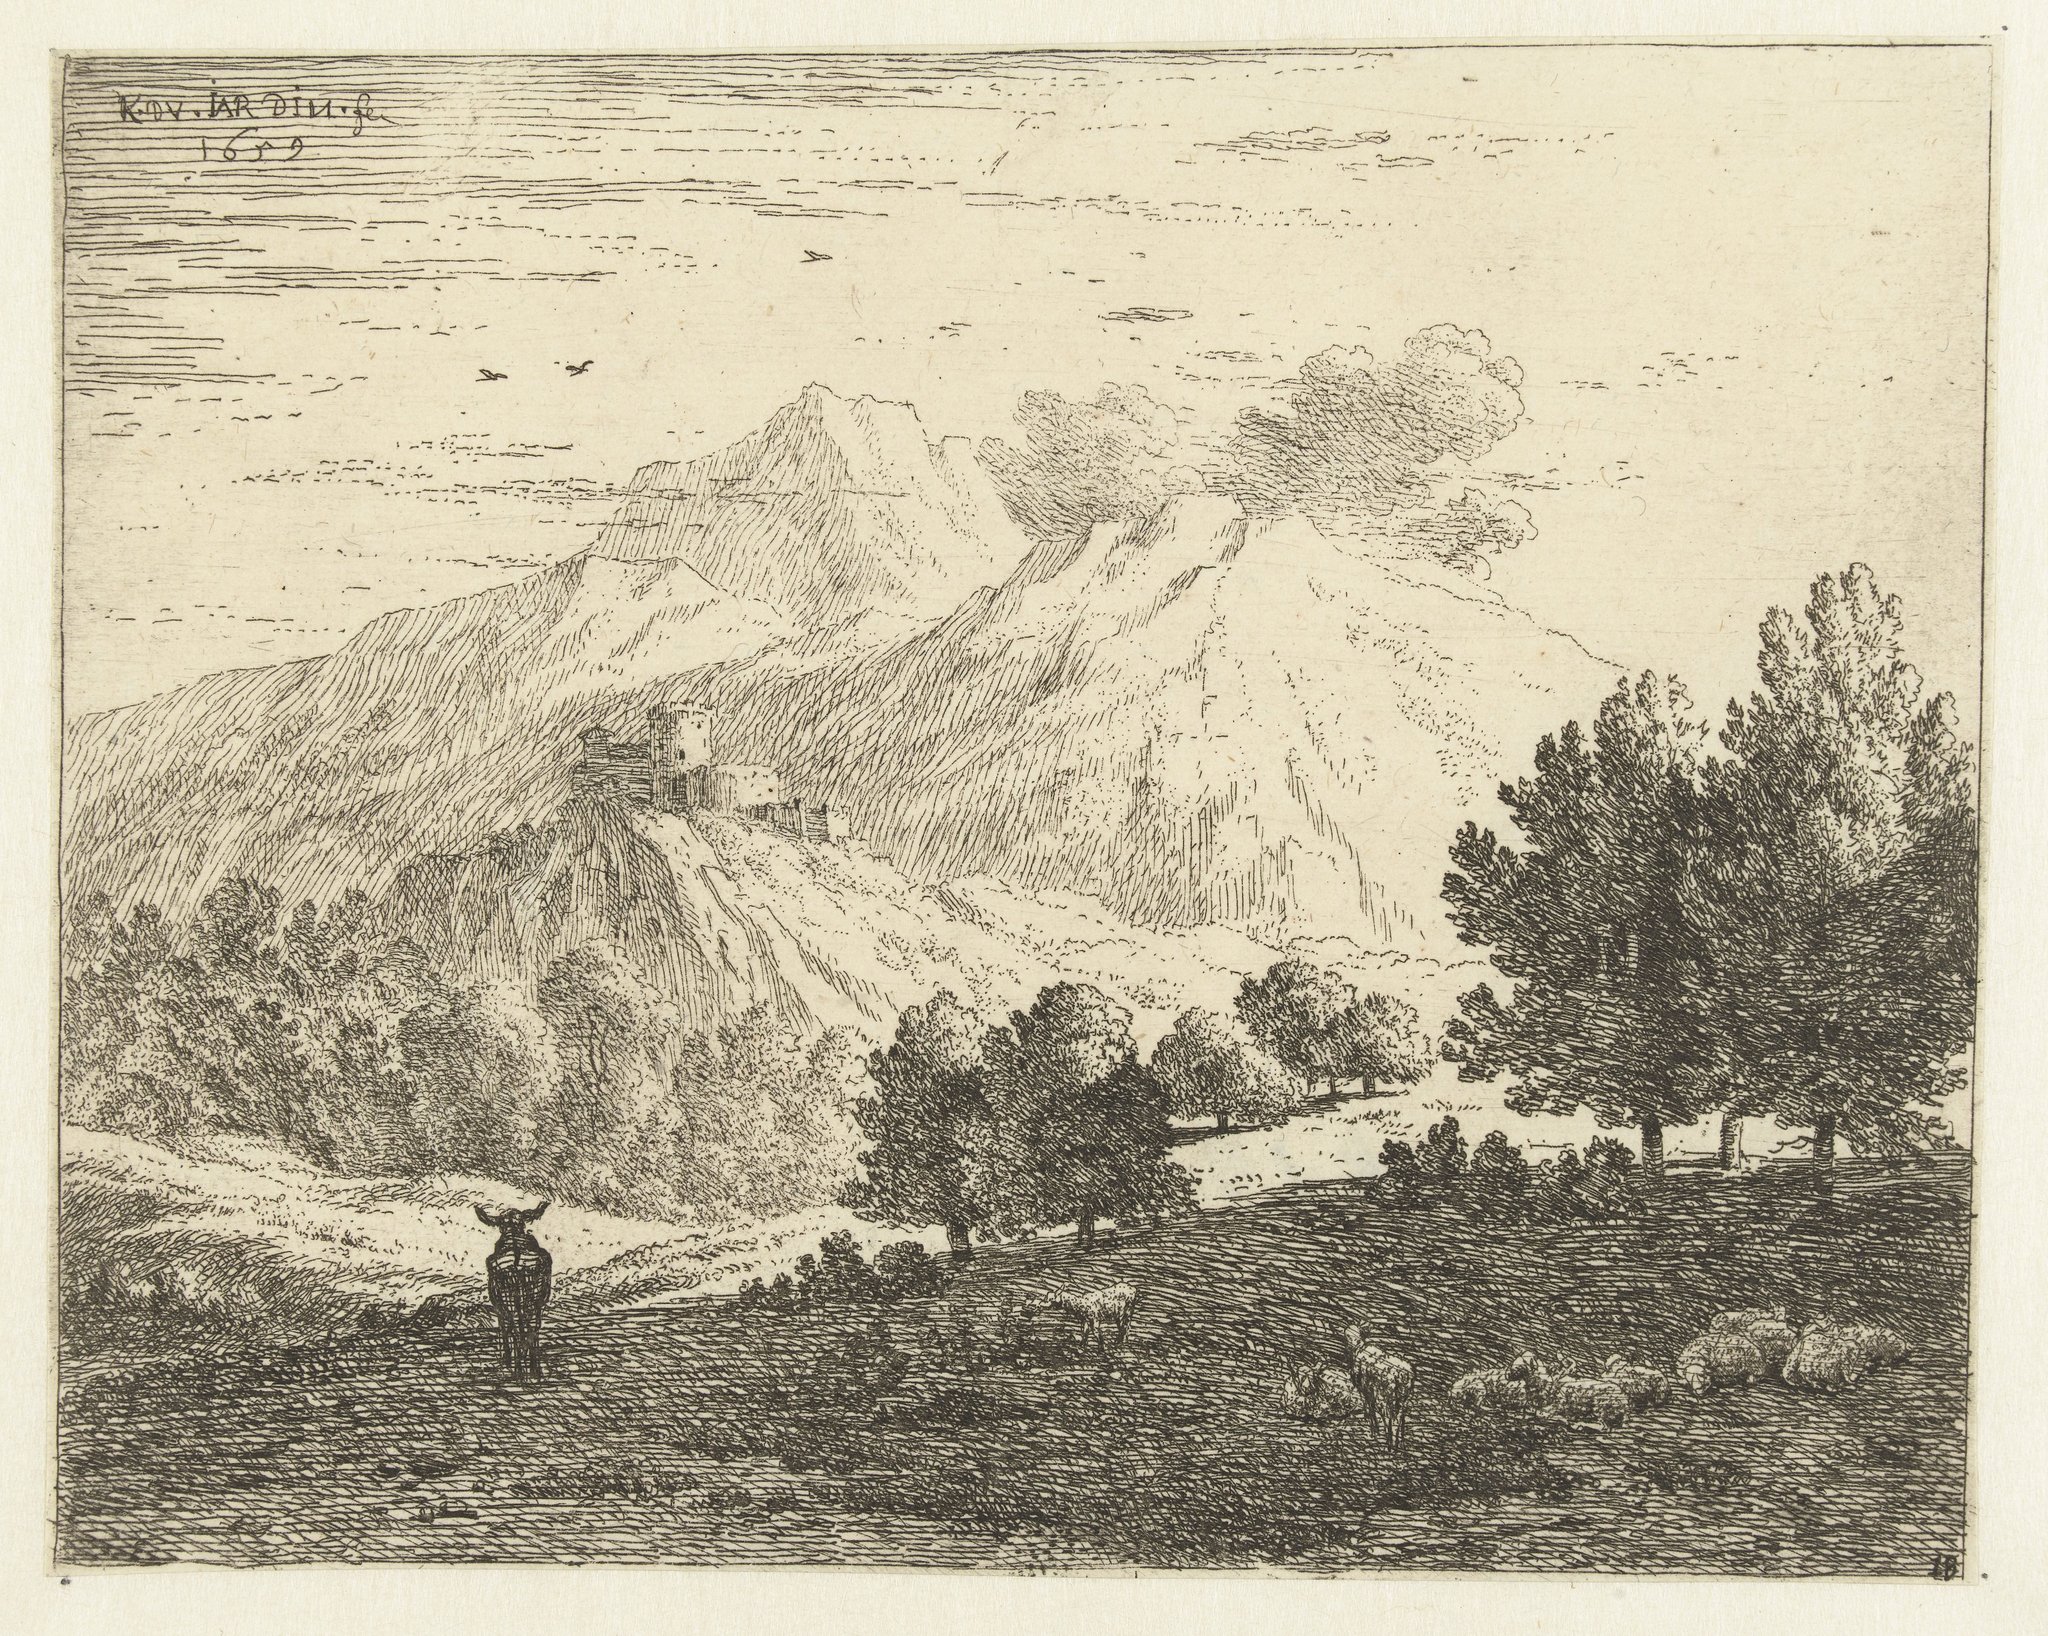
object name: print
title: Landschap met vier bergen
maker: karel du jardin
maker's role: draughtsman, painter, print maker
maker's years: 1626-1678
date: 1659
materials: paper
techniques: etching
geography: netherlands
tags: mountains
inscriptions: collector's mark: Lugt 2228a